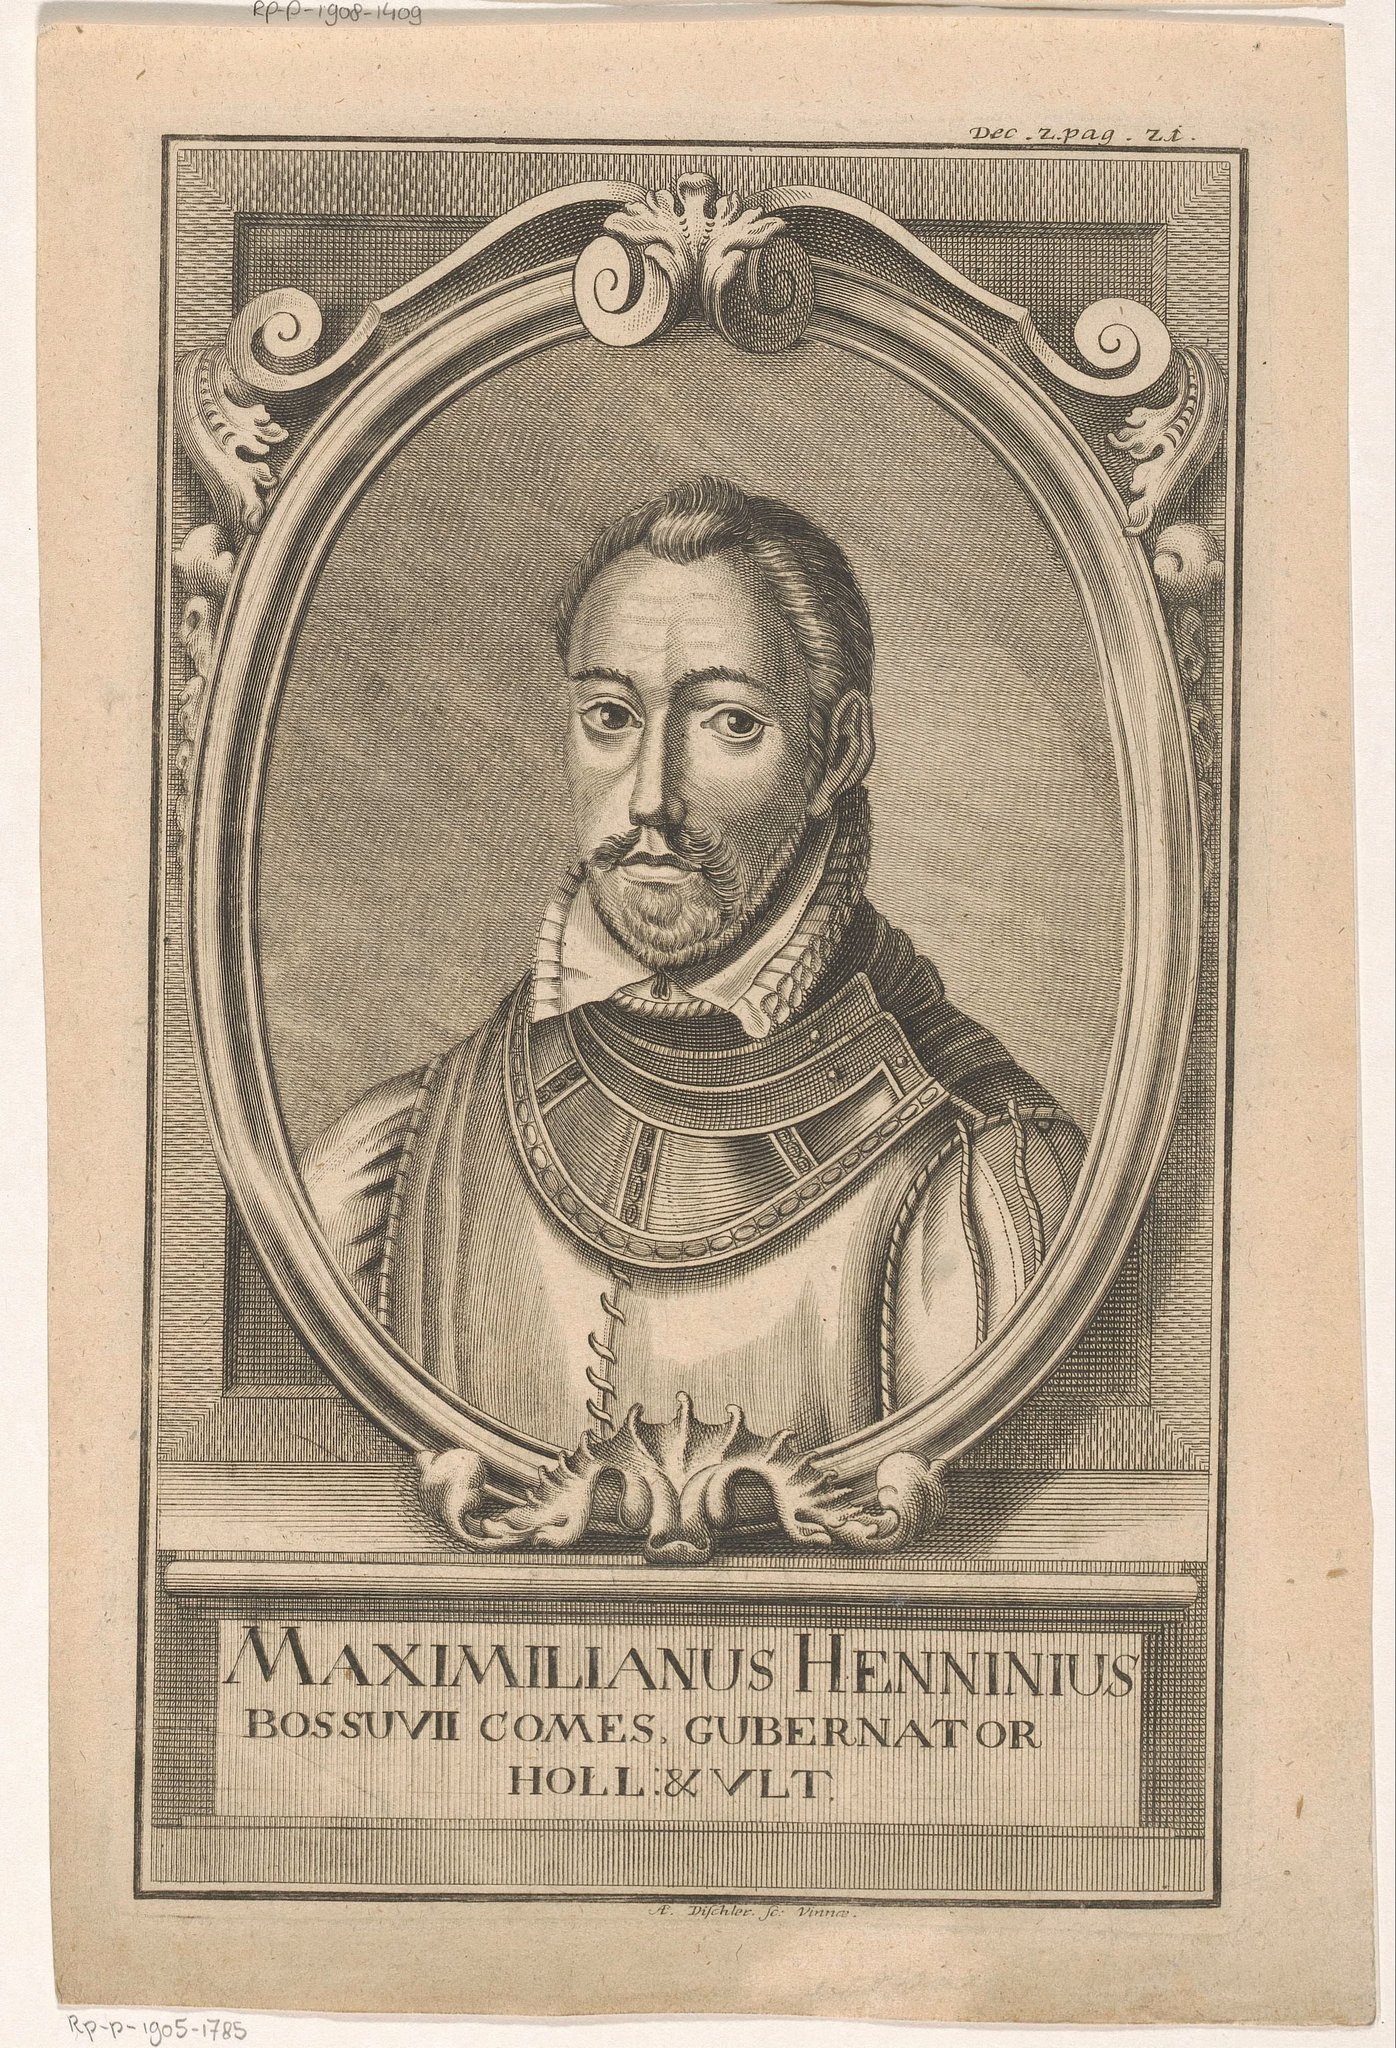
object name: book illustration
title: Portret van Maximiliaan de Hennin graaf van Boussu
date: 1731-1780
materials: paper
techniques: engraving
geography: vienna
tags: antwerp, ornament ~ medallion, historical persons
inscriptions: collector's mark: Lugt 2228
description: Prent gebruikt voor: Strada, Famiano. De bello belgico, ab excessu Caroli V. Imp. usque ad initia praefecturae Alexandri Farnesii Parmae et Placentiae Ducis III (...). Wenen: Emericus Felix Bader, 1754.